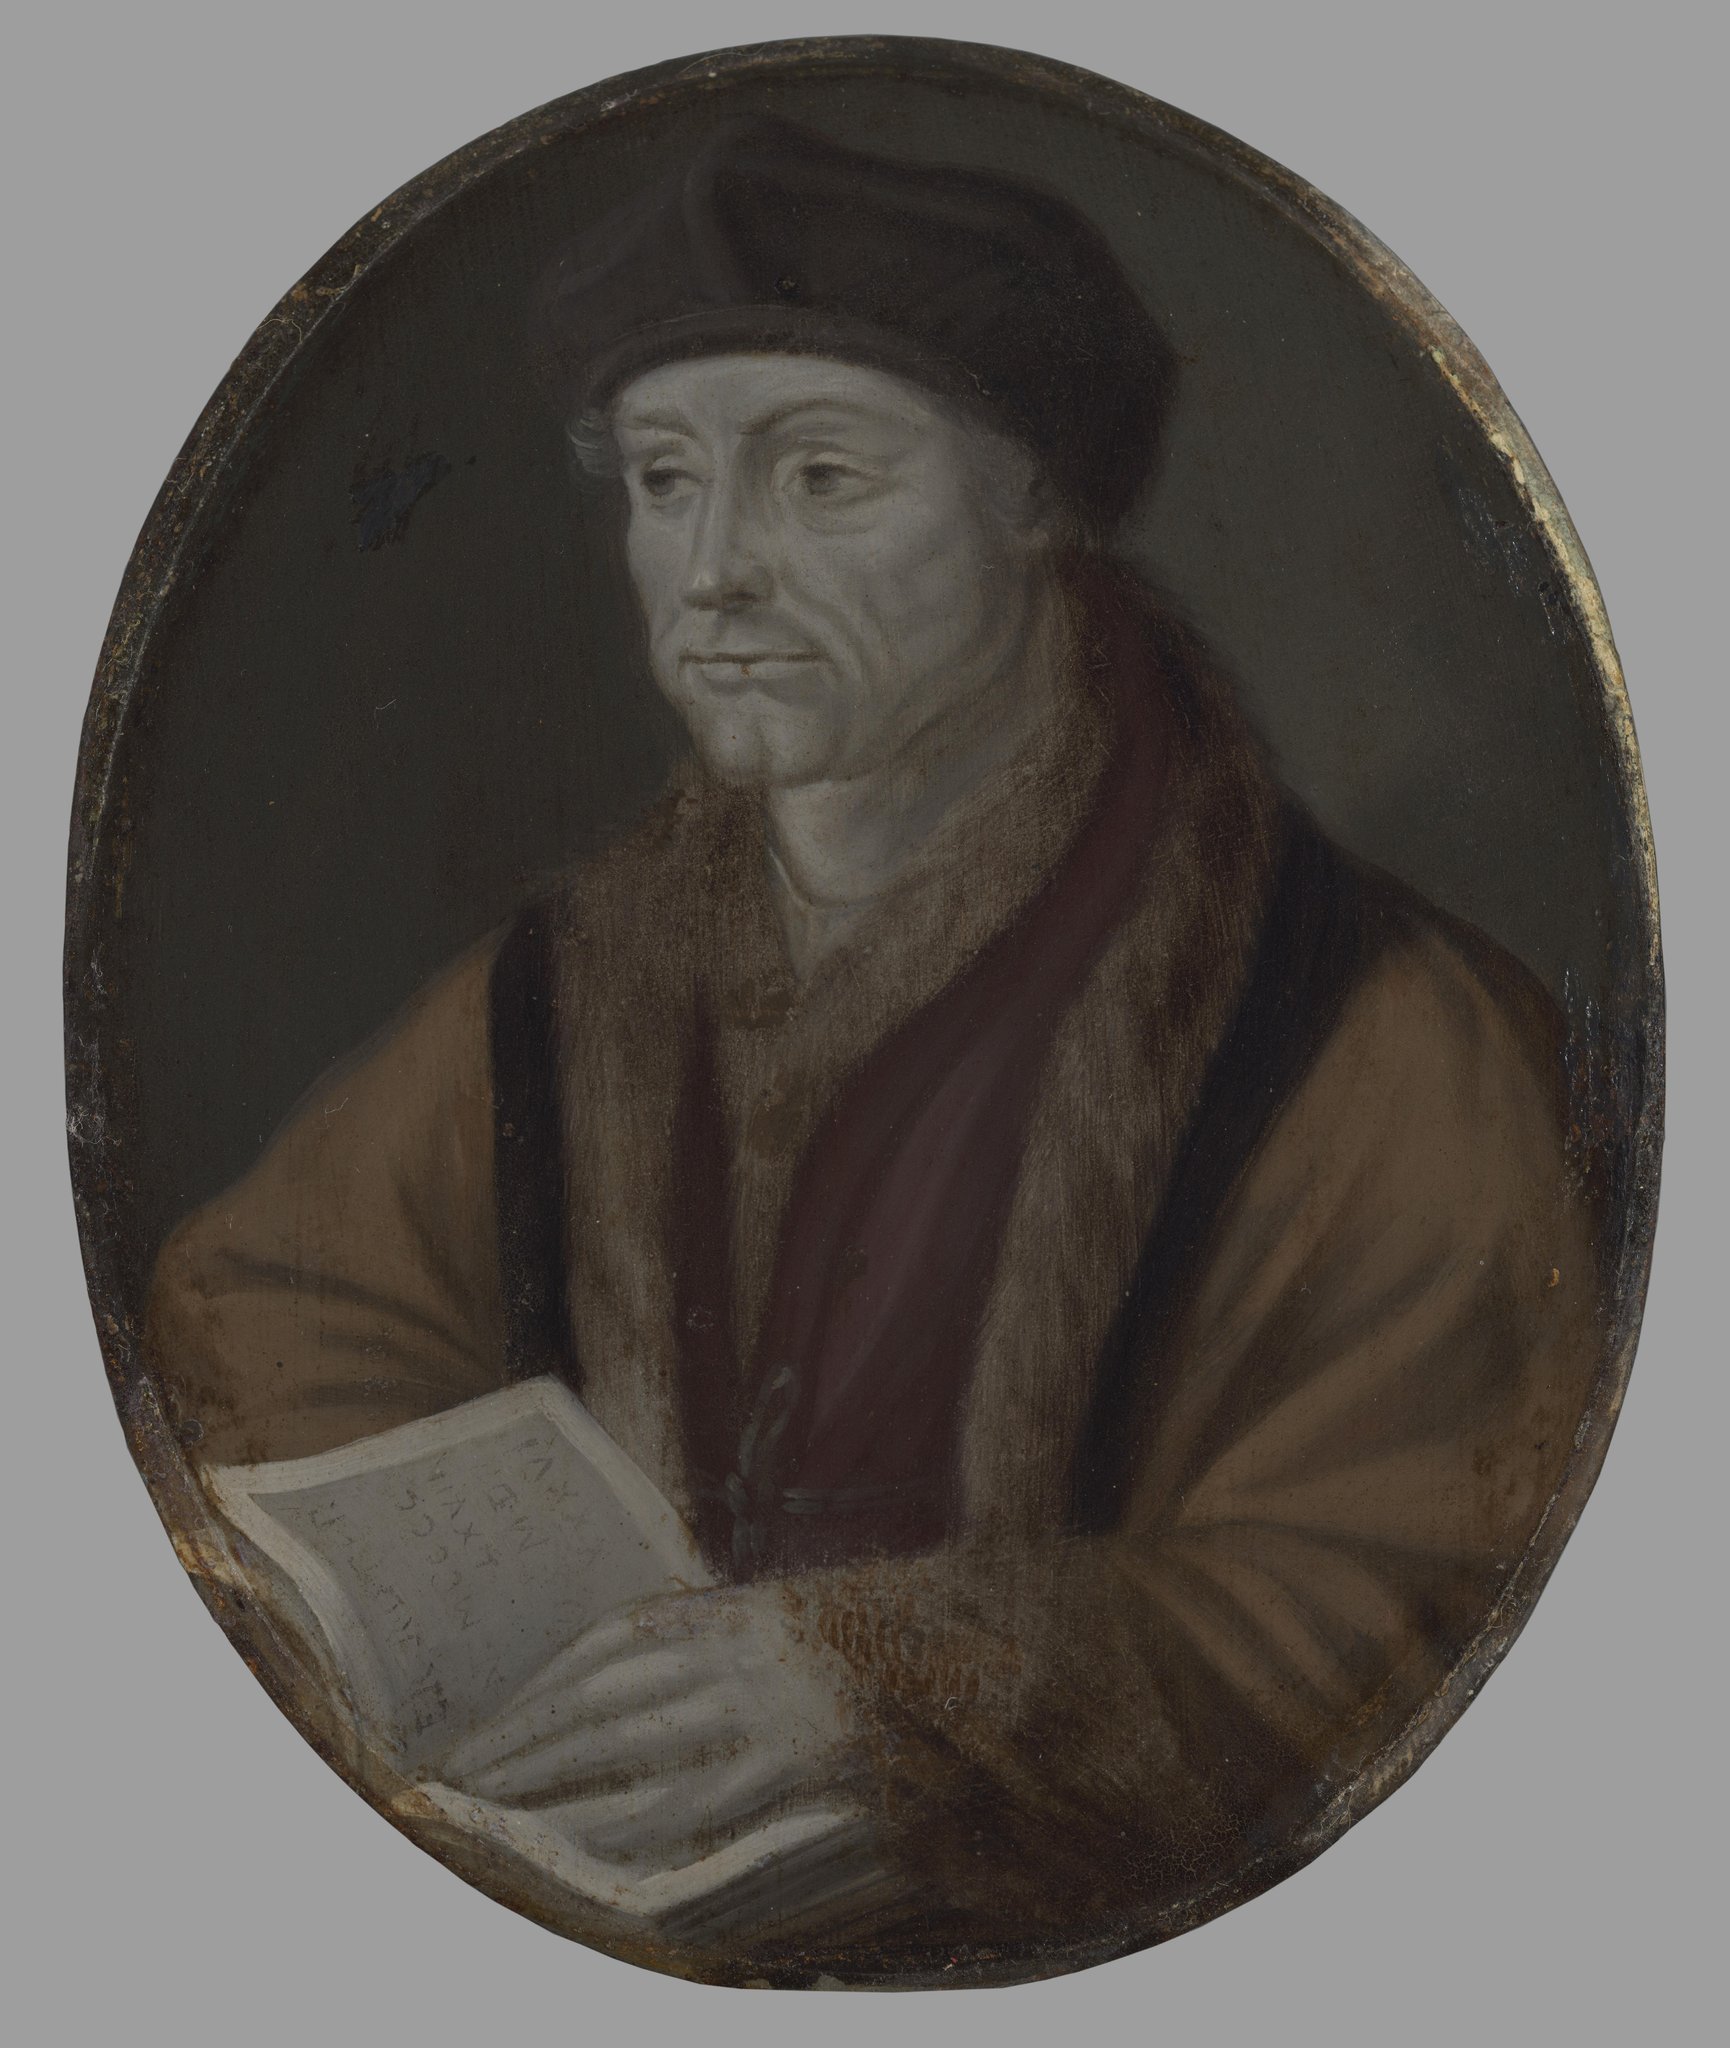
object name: painting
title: Desiderius Erasmus (1466-1536). Priester, theoloog, humanist en schrijver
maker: arnoud van halen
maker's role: draughtsman, painter, print maker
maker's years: 1673-1732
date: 1700-1720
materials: iron, oil, paint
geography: amsterdam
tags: rotterdam, desiderius erasmus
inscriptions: inscription: ‘Erasmus Van Rotterdam/ 3’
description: Portret van Desiderius Erasmus (1466-1536). Buste in ovaal, naar links. Onderdeel van het Panpoëticon Batâvum, een verzameling portretten van Nederlandse dichters.